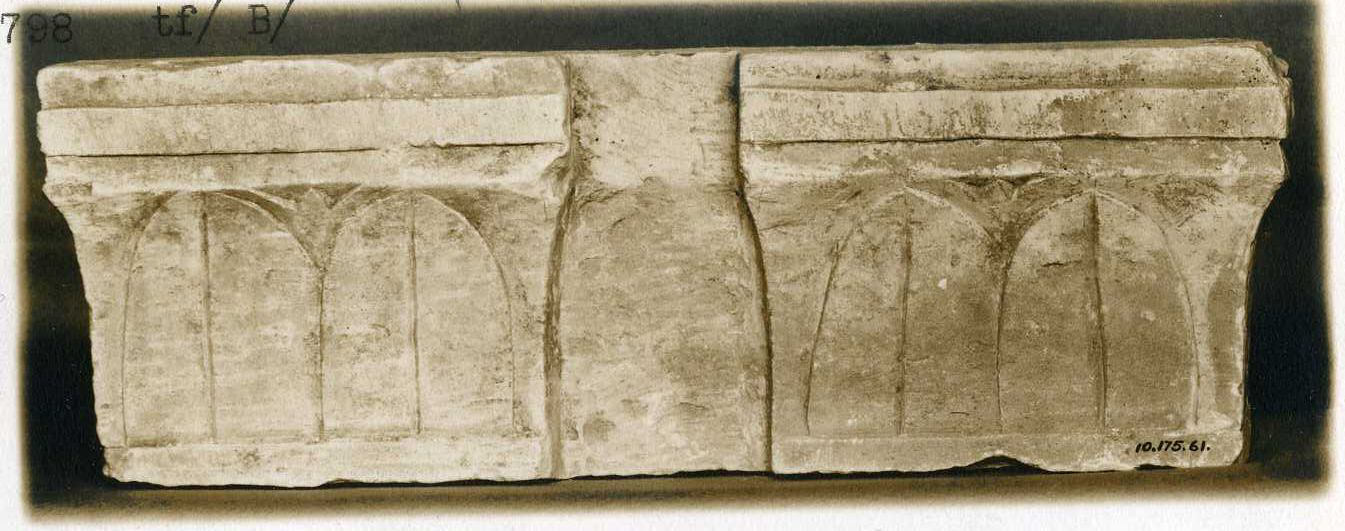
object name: capital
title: Capital with Palm Leaves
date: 501-700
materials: limestone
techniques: carving, relief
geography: egypt